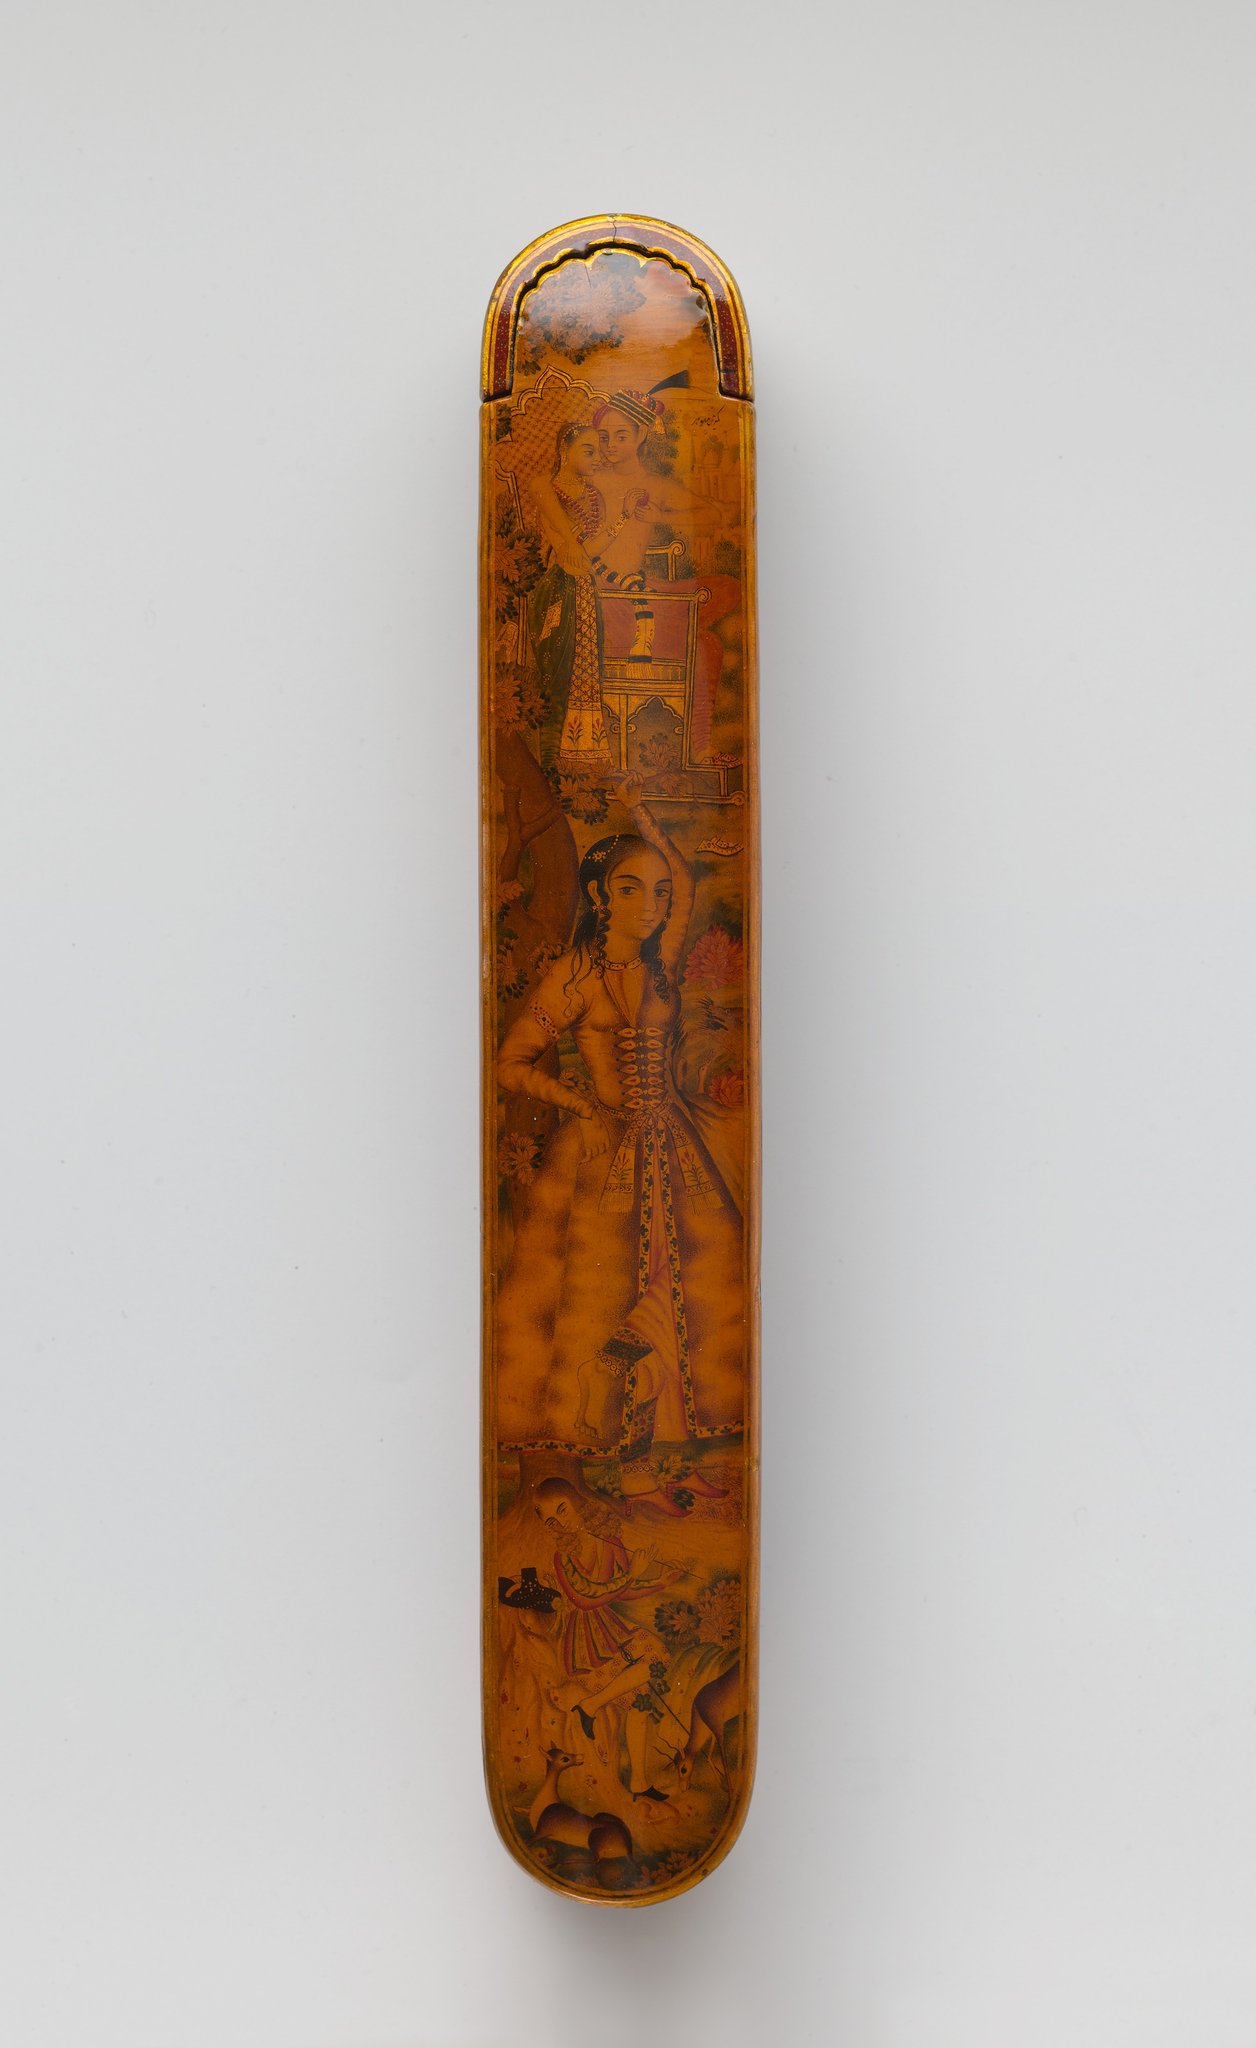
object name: pen box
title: Lacquered Pen Box (Qalamdan)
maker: manohar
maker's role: maker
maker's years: 1577-1624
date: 1667-1733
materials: paper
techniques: gilding, lacquer, painting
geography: deccan or northern india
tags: men,women,deer